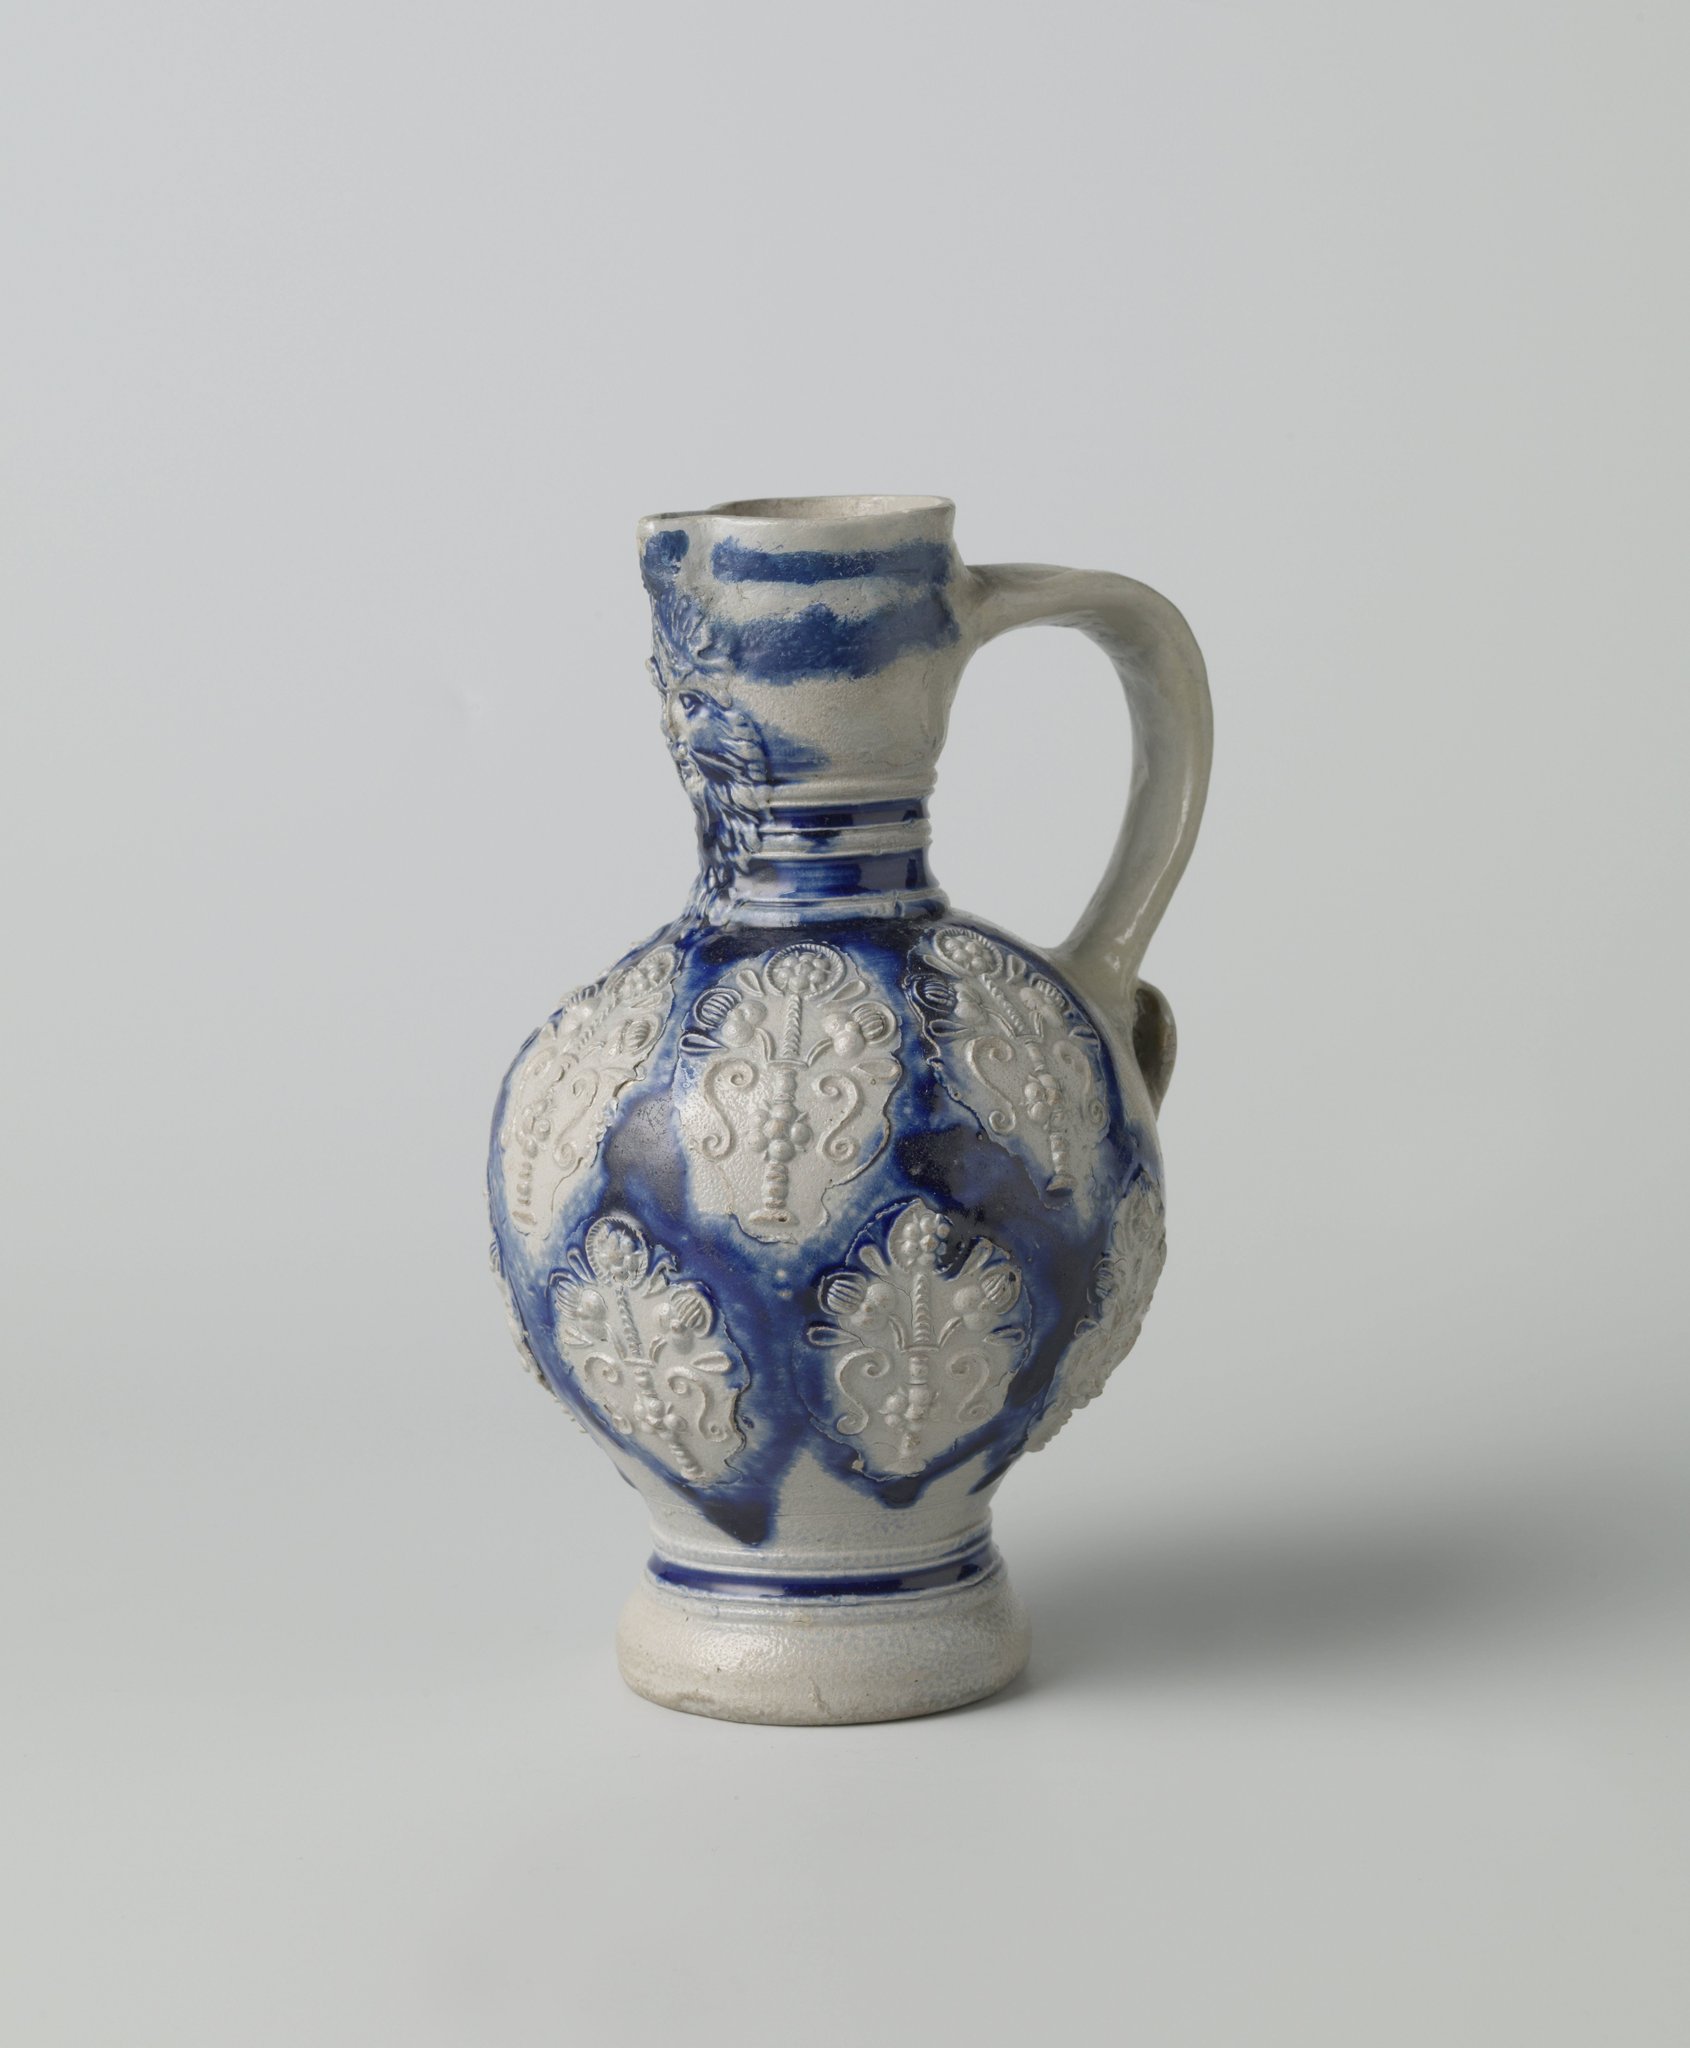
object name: ewer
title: Jug with a mask and flower vases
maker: Anonymous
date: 1650-1680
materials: cobalt, glaze, stoneware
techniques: firing, forming, relief, turning, vitrification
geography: westerwald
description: Kan van steengoed op hoge voet met een smalle nek, eivormig lichaam en in de rand een geknepen tuit. Het C-vormige oor is bevestigd aan de nek en de schouder. Gedeeltelijk op het glazuur bedekt met kobaltblauw. Op de voet en de nek enkele ingegrifte lijnen. De kan is versierd met een reliëfdecoratie waarbij de buik grotendeels is bedekt met gedrukte, opgelegde bloemenvazen tegen een blauwe achtergrond. Op de nek onder de tuit is een gemodelleerd masker aangebracht. Westerwald.